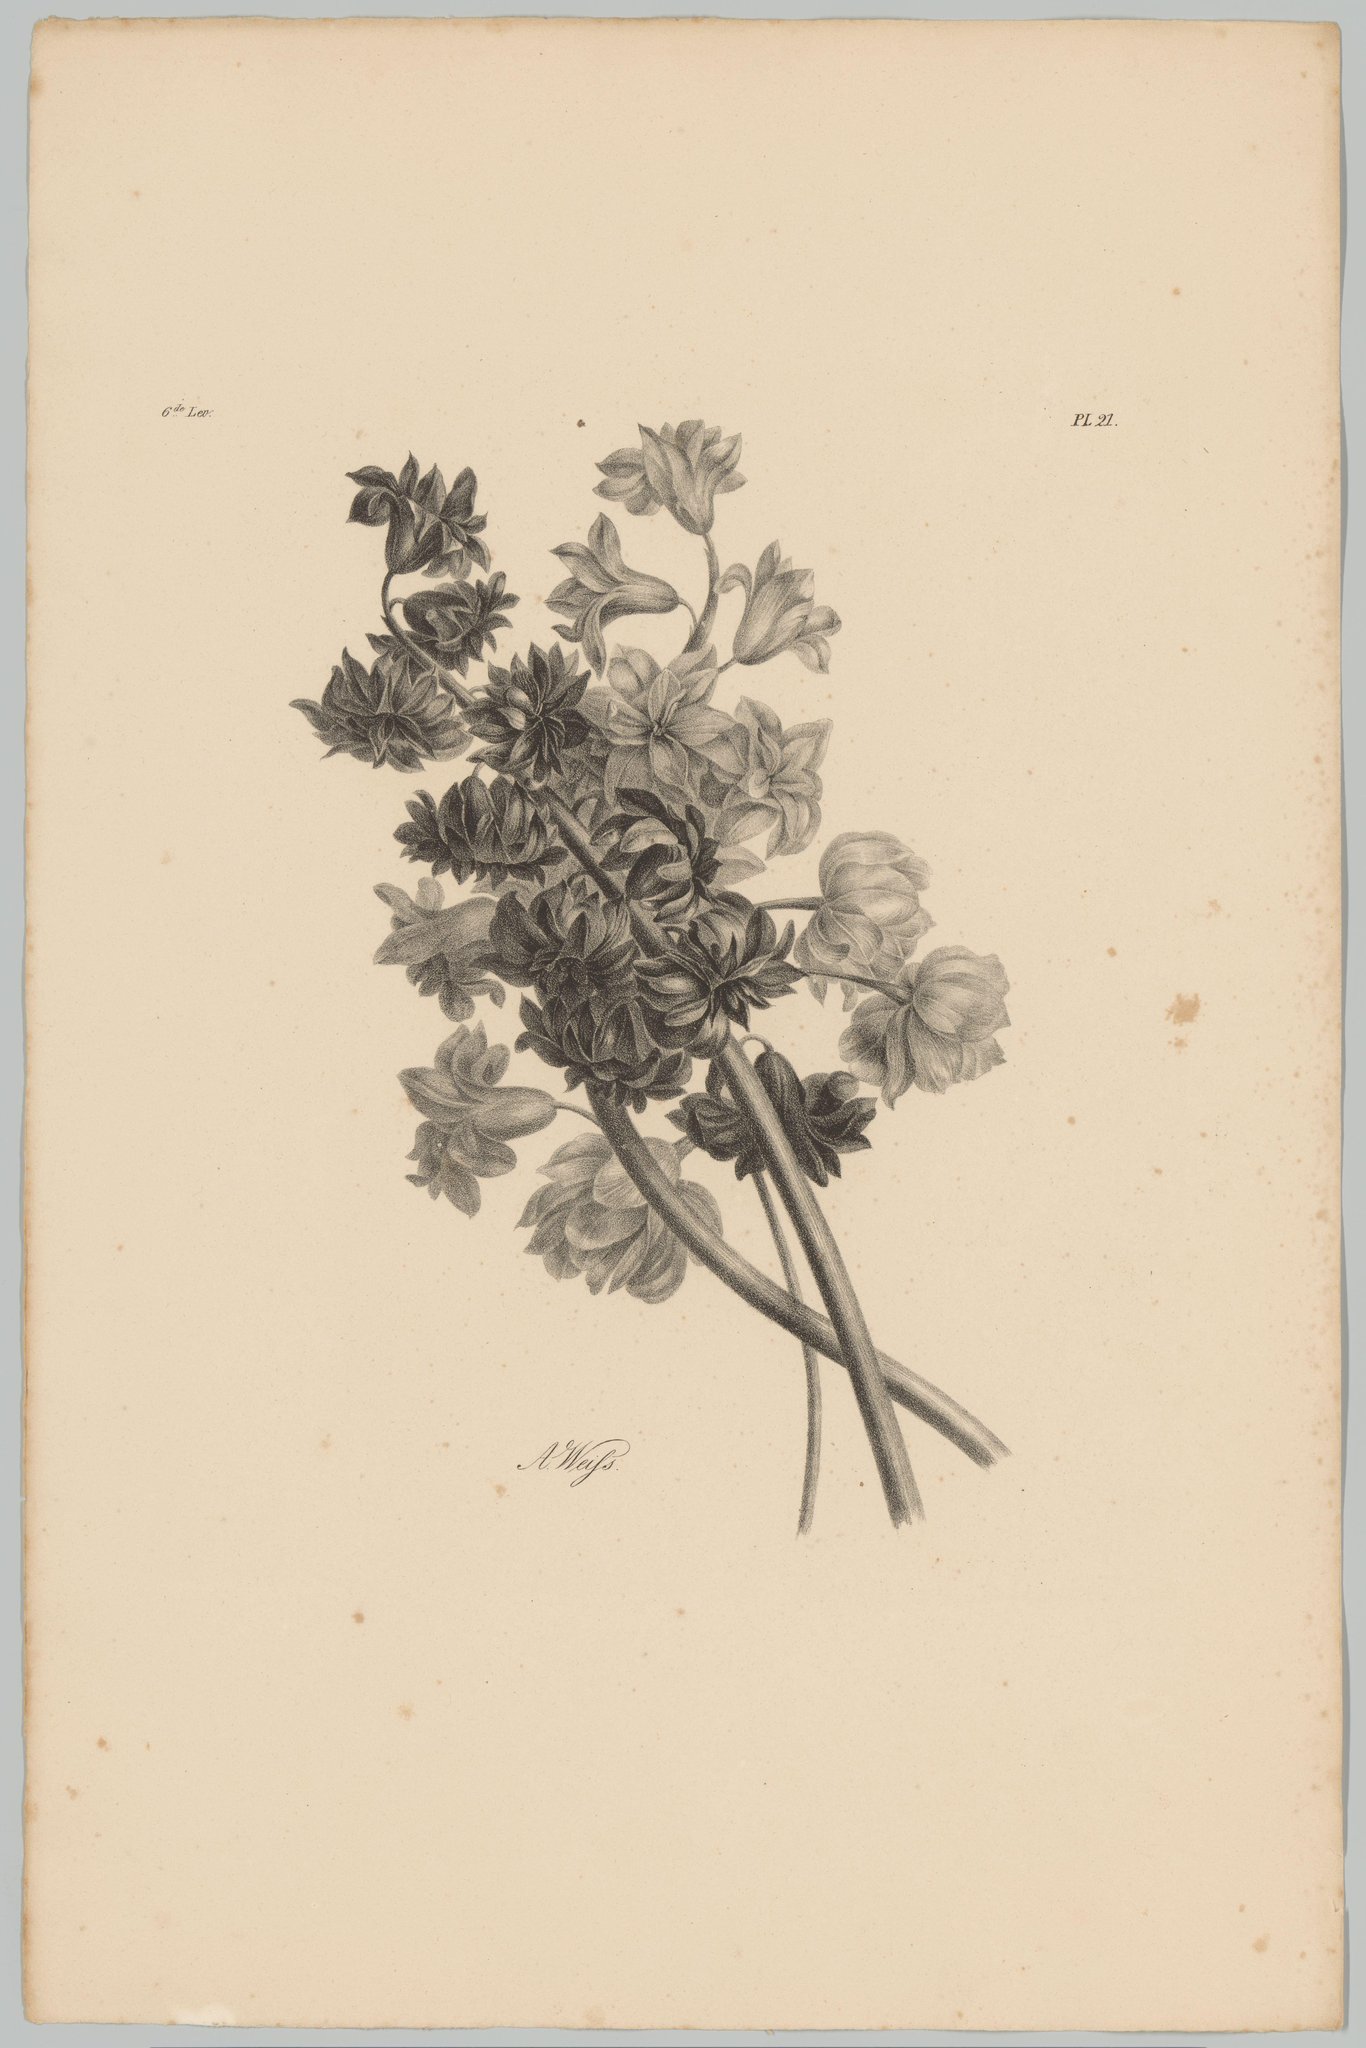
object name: print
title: Bloem en Fruit Studien (...) 3de aflevering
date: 1820-1833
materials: paper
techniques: lithograph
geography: amsterdam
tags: flowers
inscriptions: collector's mark: Lugt 2228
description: Links boven genummerd 6de Lev. Onderdeel van een omslag met in totaal zevenenzeventig lithografieën van bloemen en fruit.